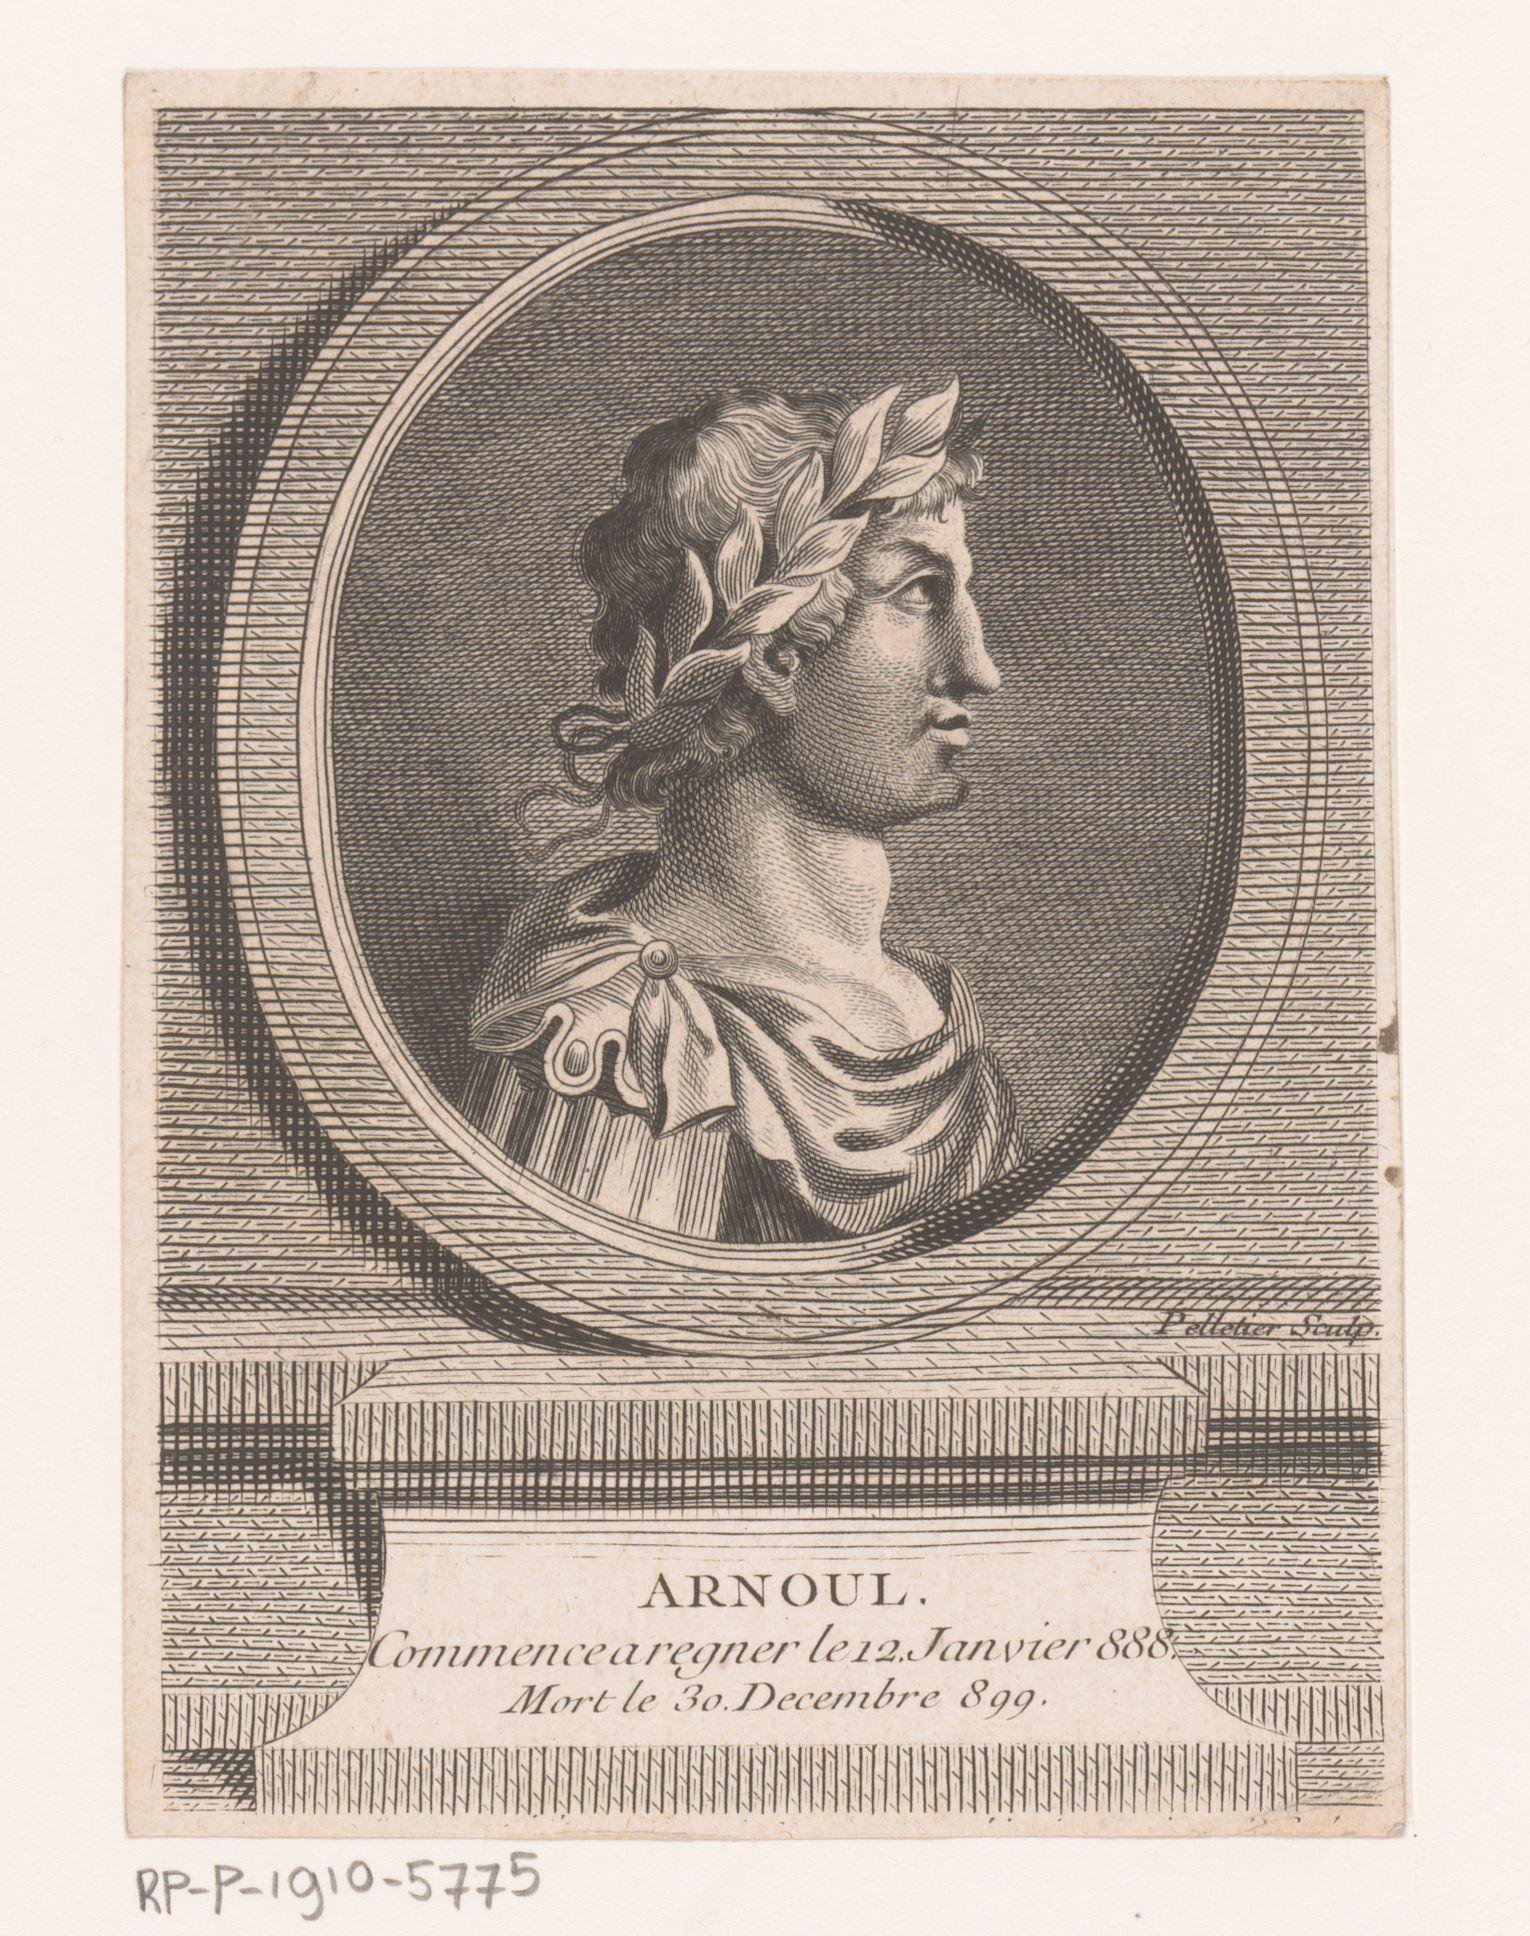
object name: print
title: Portret van Arnulf van Karinthië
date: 1755-1765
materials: paper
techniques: engraving, etching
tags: historical persons, king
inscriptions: collector's mark: Lugt 2228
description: Prent als illustratie gebruikt voor het boek: Dreux de Radier, Jean François. L'Europe illustre. Parijs: Michel Odieuvre, 1755-1765.